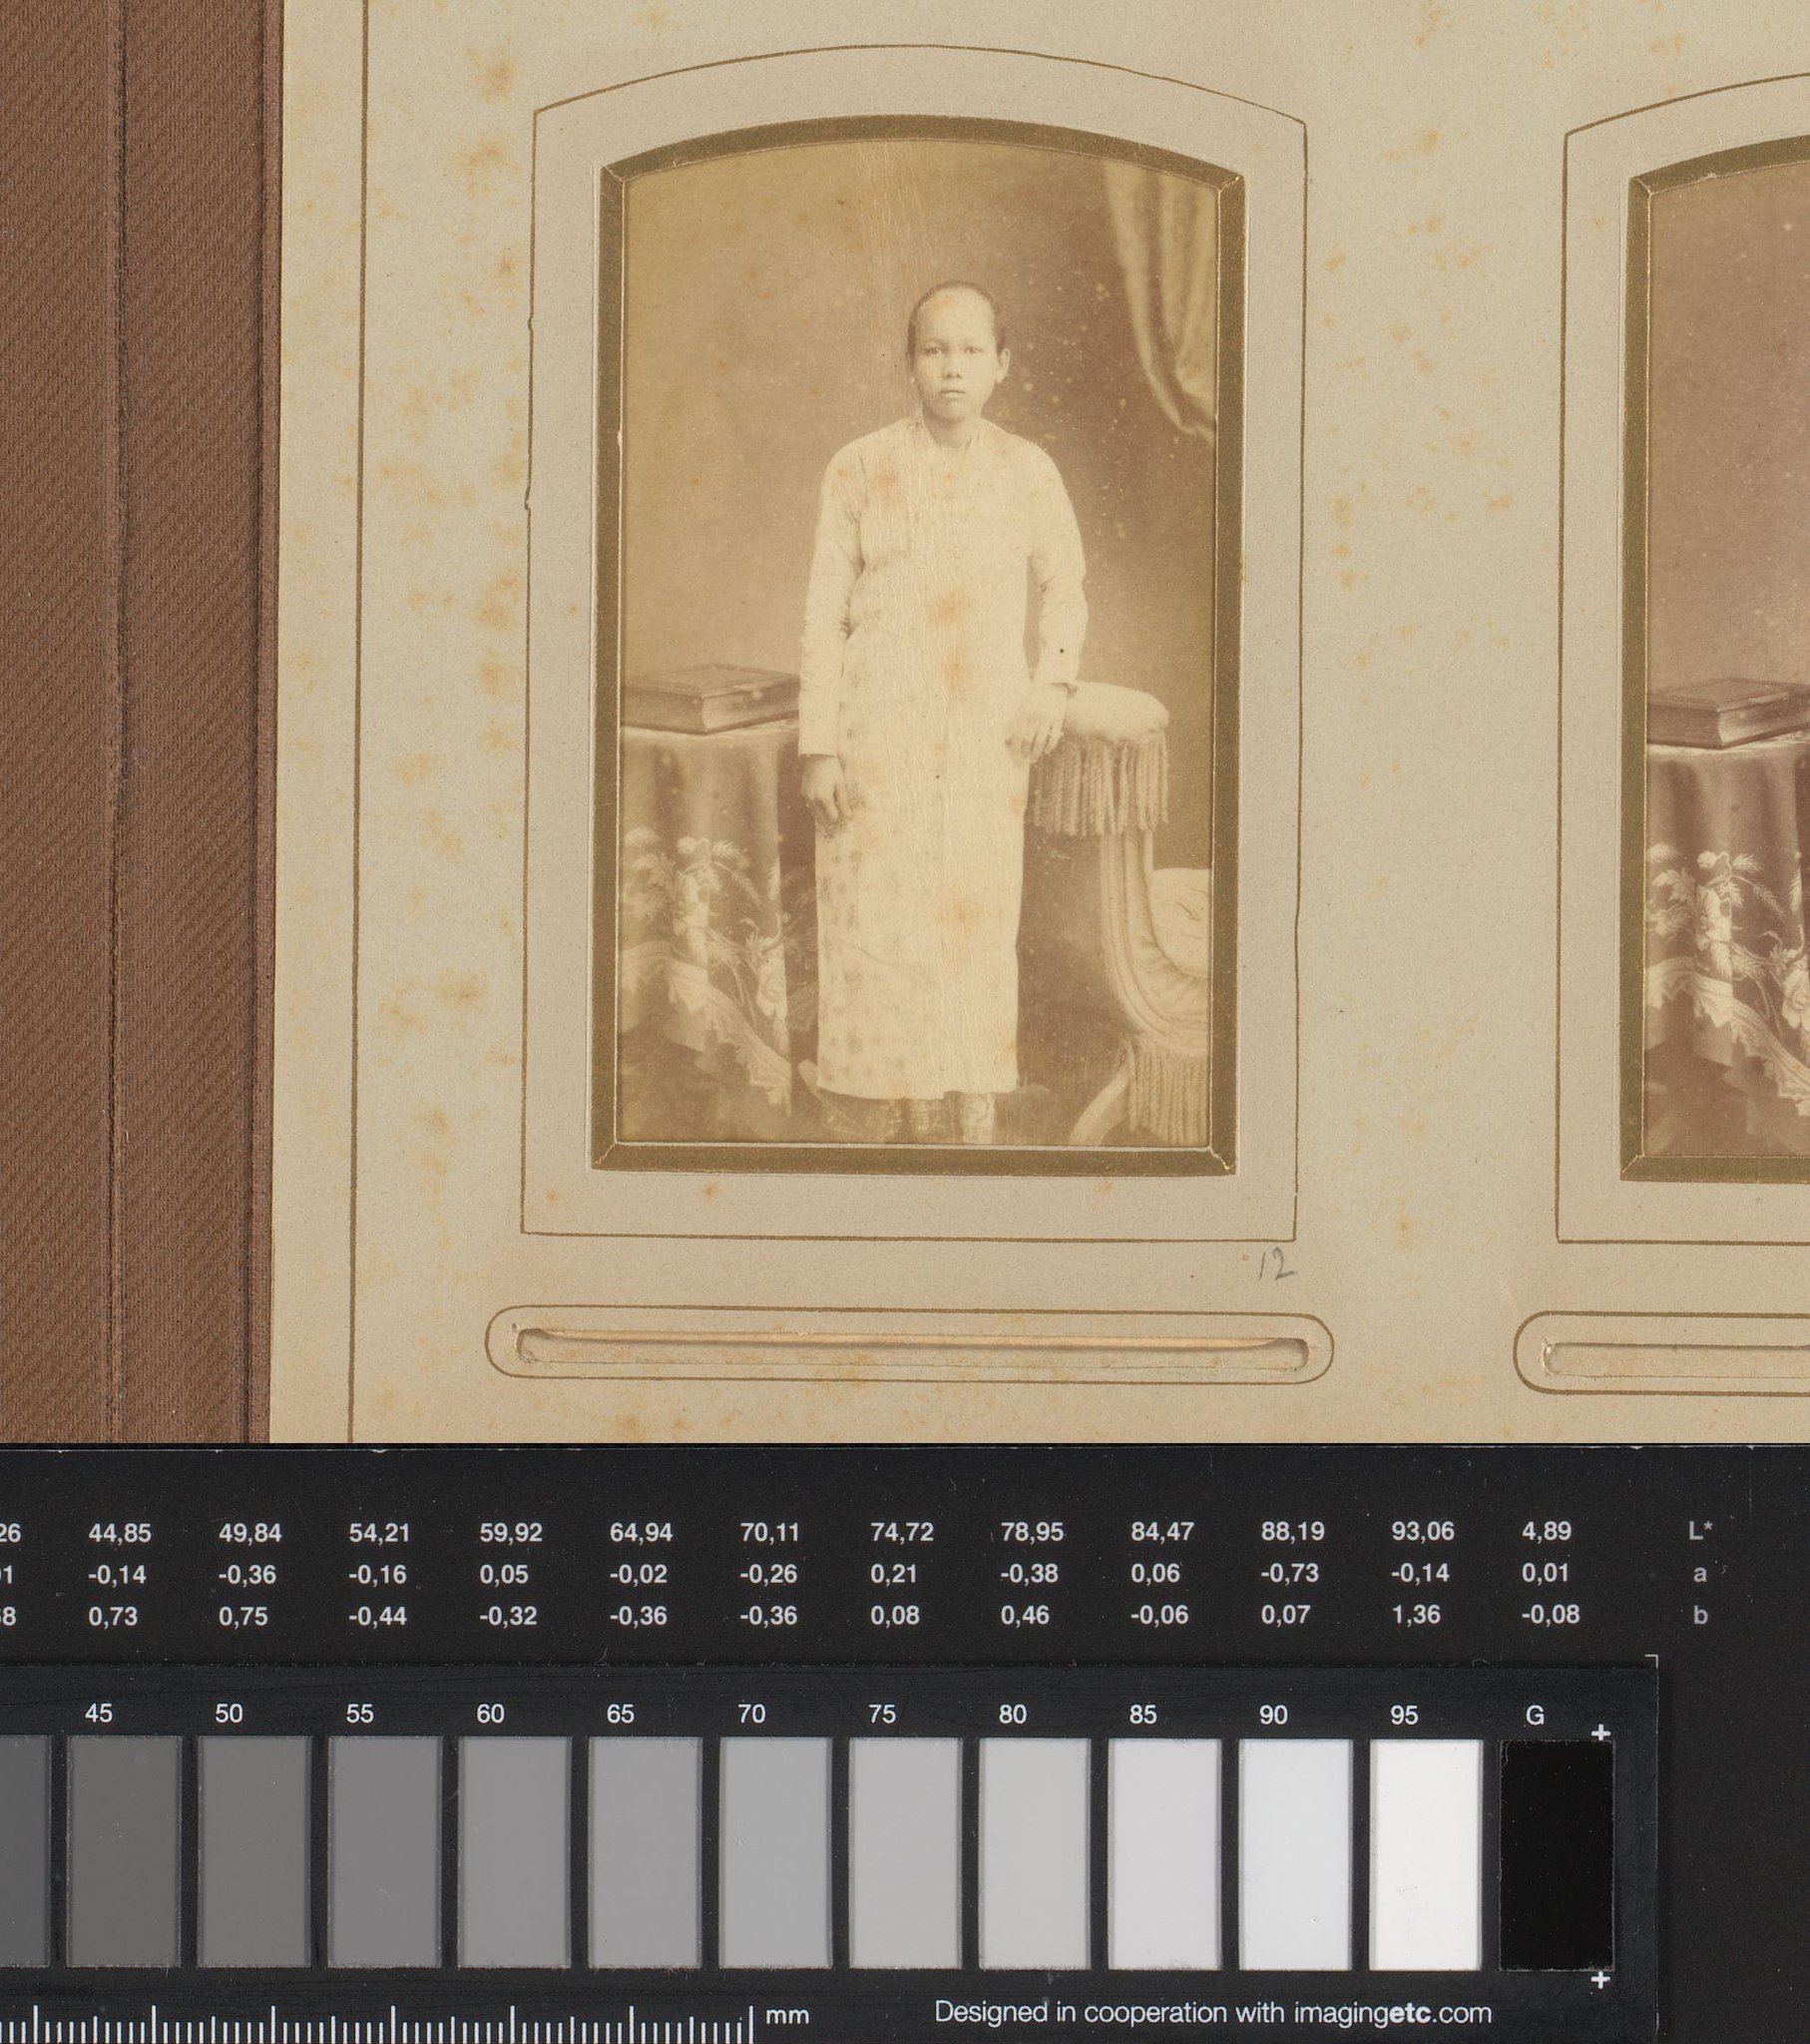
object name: carte de visite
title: Sacra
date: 1880-1890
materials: paper, photographic support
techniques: photography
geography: jakarta